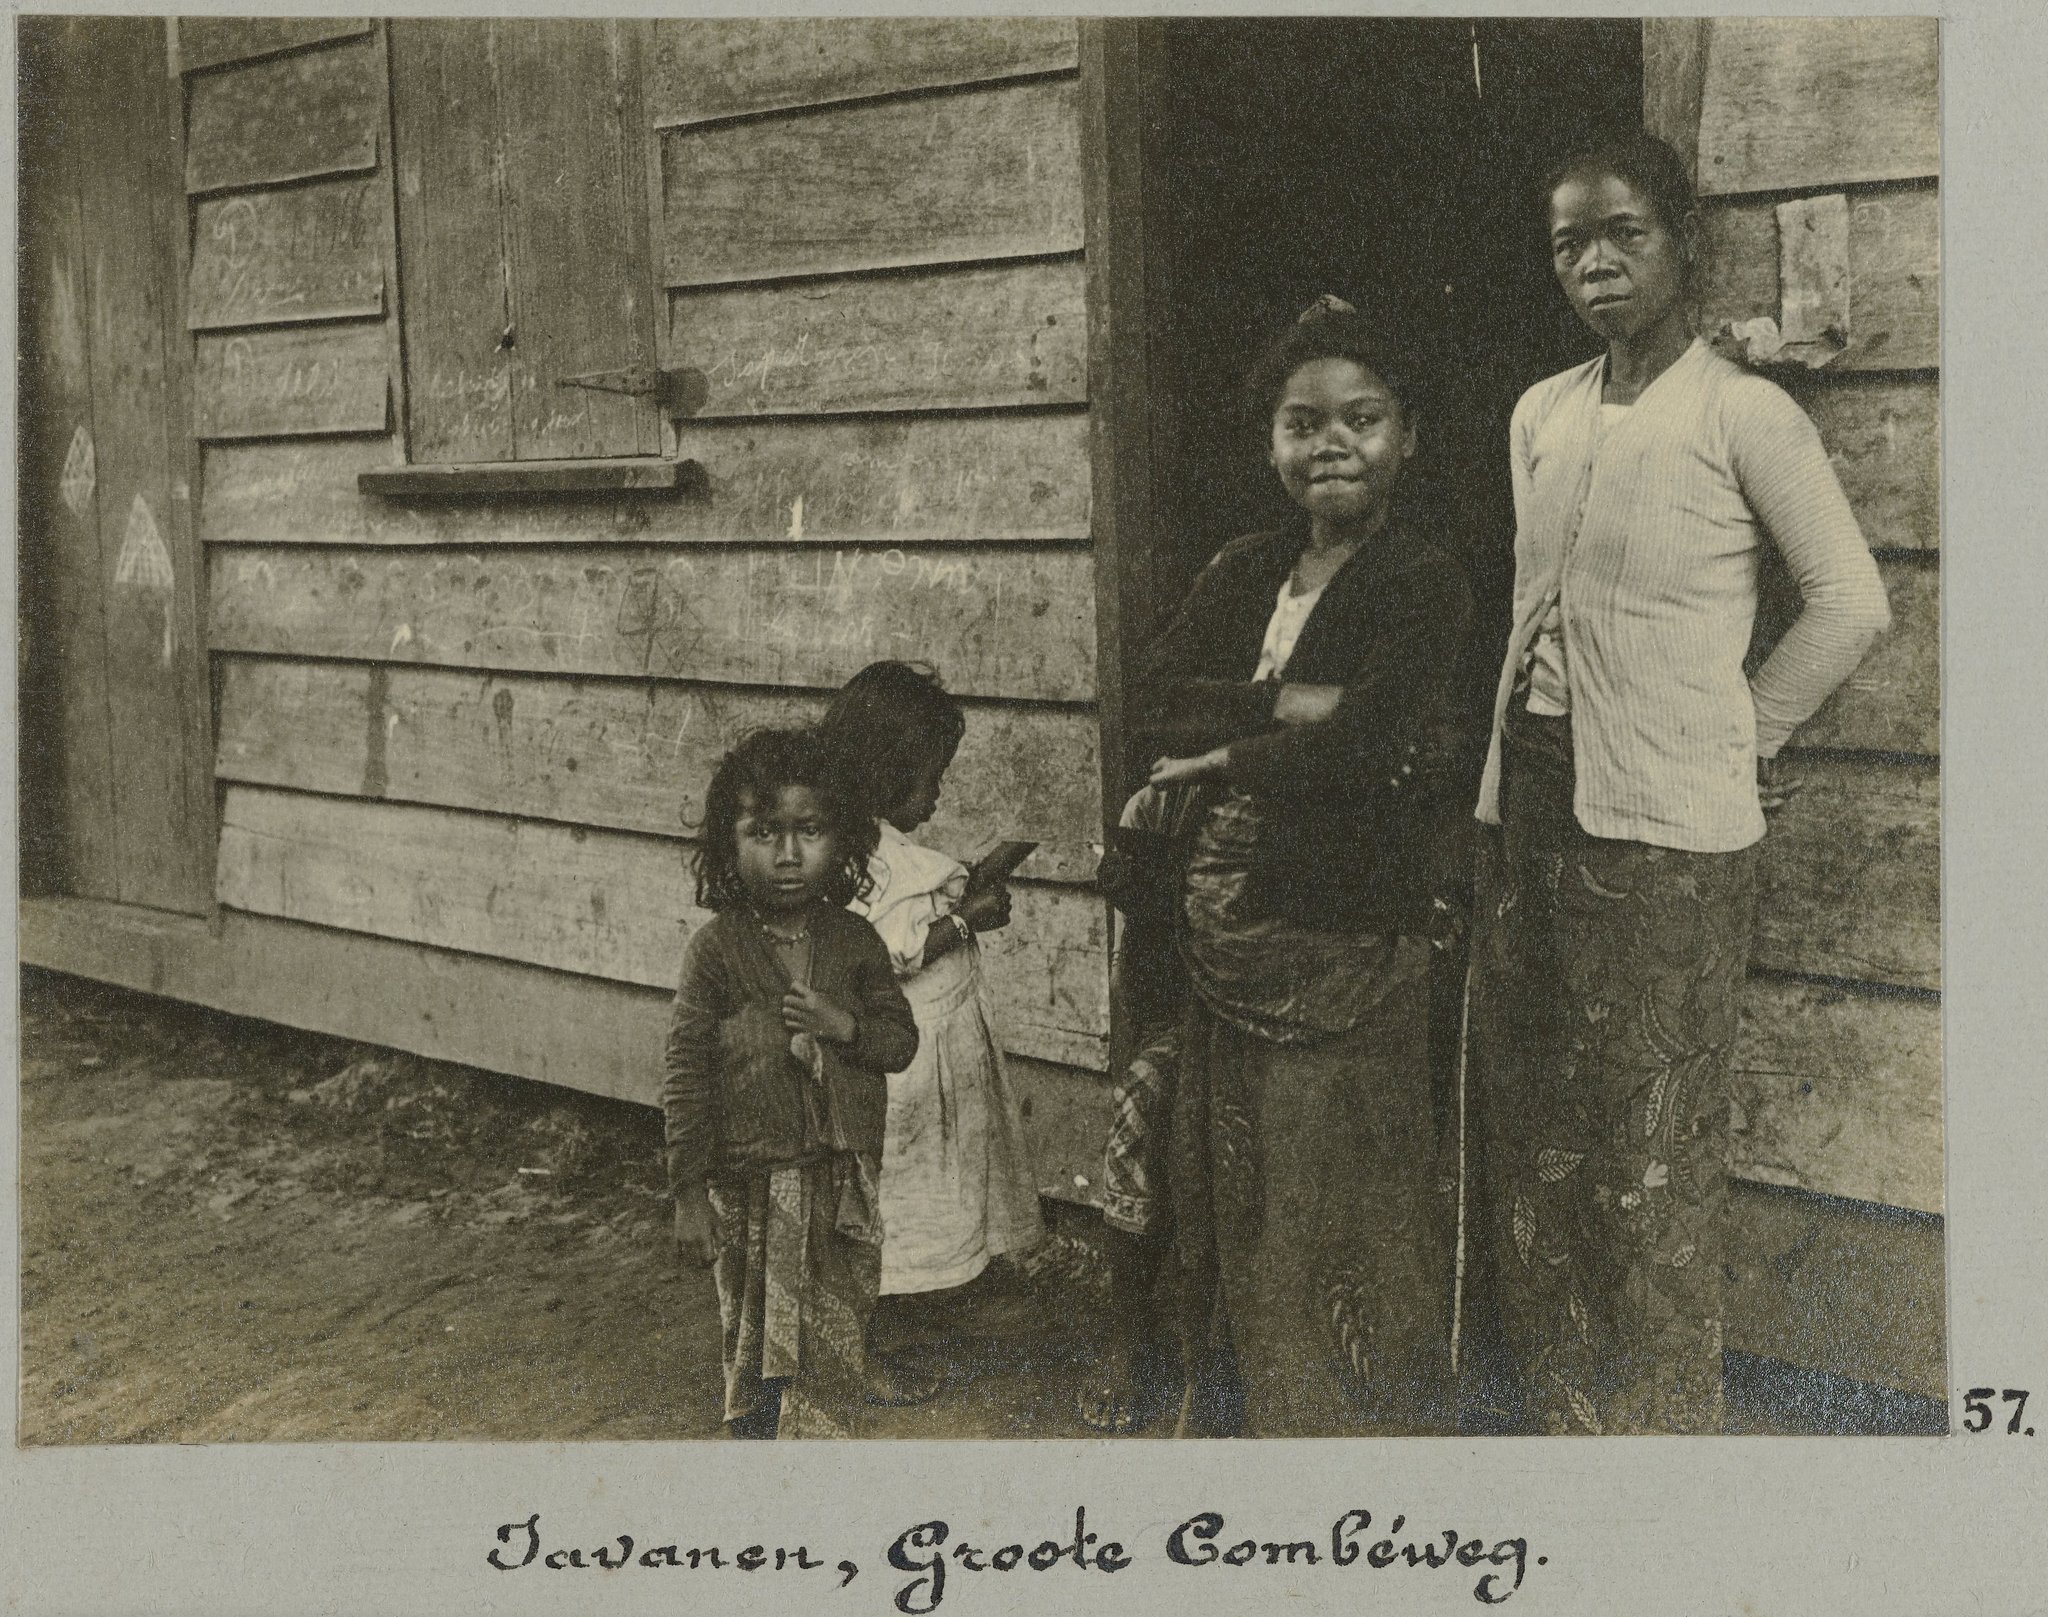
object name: photograph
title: Javanen, Groote Combéweg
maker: hendrik doijer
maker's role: engineer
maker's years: 1863-1925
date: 1903-1910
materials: photographic support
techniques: gelatin silver print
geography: suriname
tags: suriname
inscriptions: inscription: ‘57. / Javanen, Groote Combéweg.’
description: Twee Javaanse vrouwen en twee meisjes staand in de deur van een houten huis aan de Grote Combéweg te Paramaribo. Onderdeel van het fotoalbum Souvenir de Voyage (deel 2), over het leven van de familie Doijer in en rond de plantage Ma Retraite in Suriname in de jaren 1903-1910.